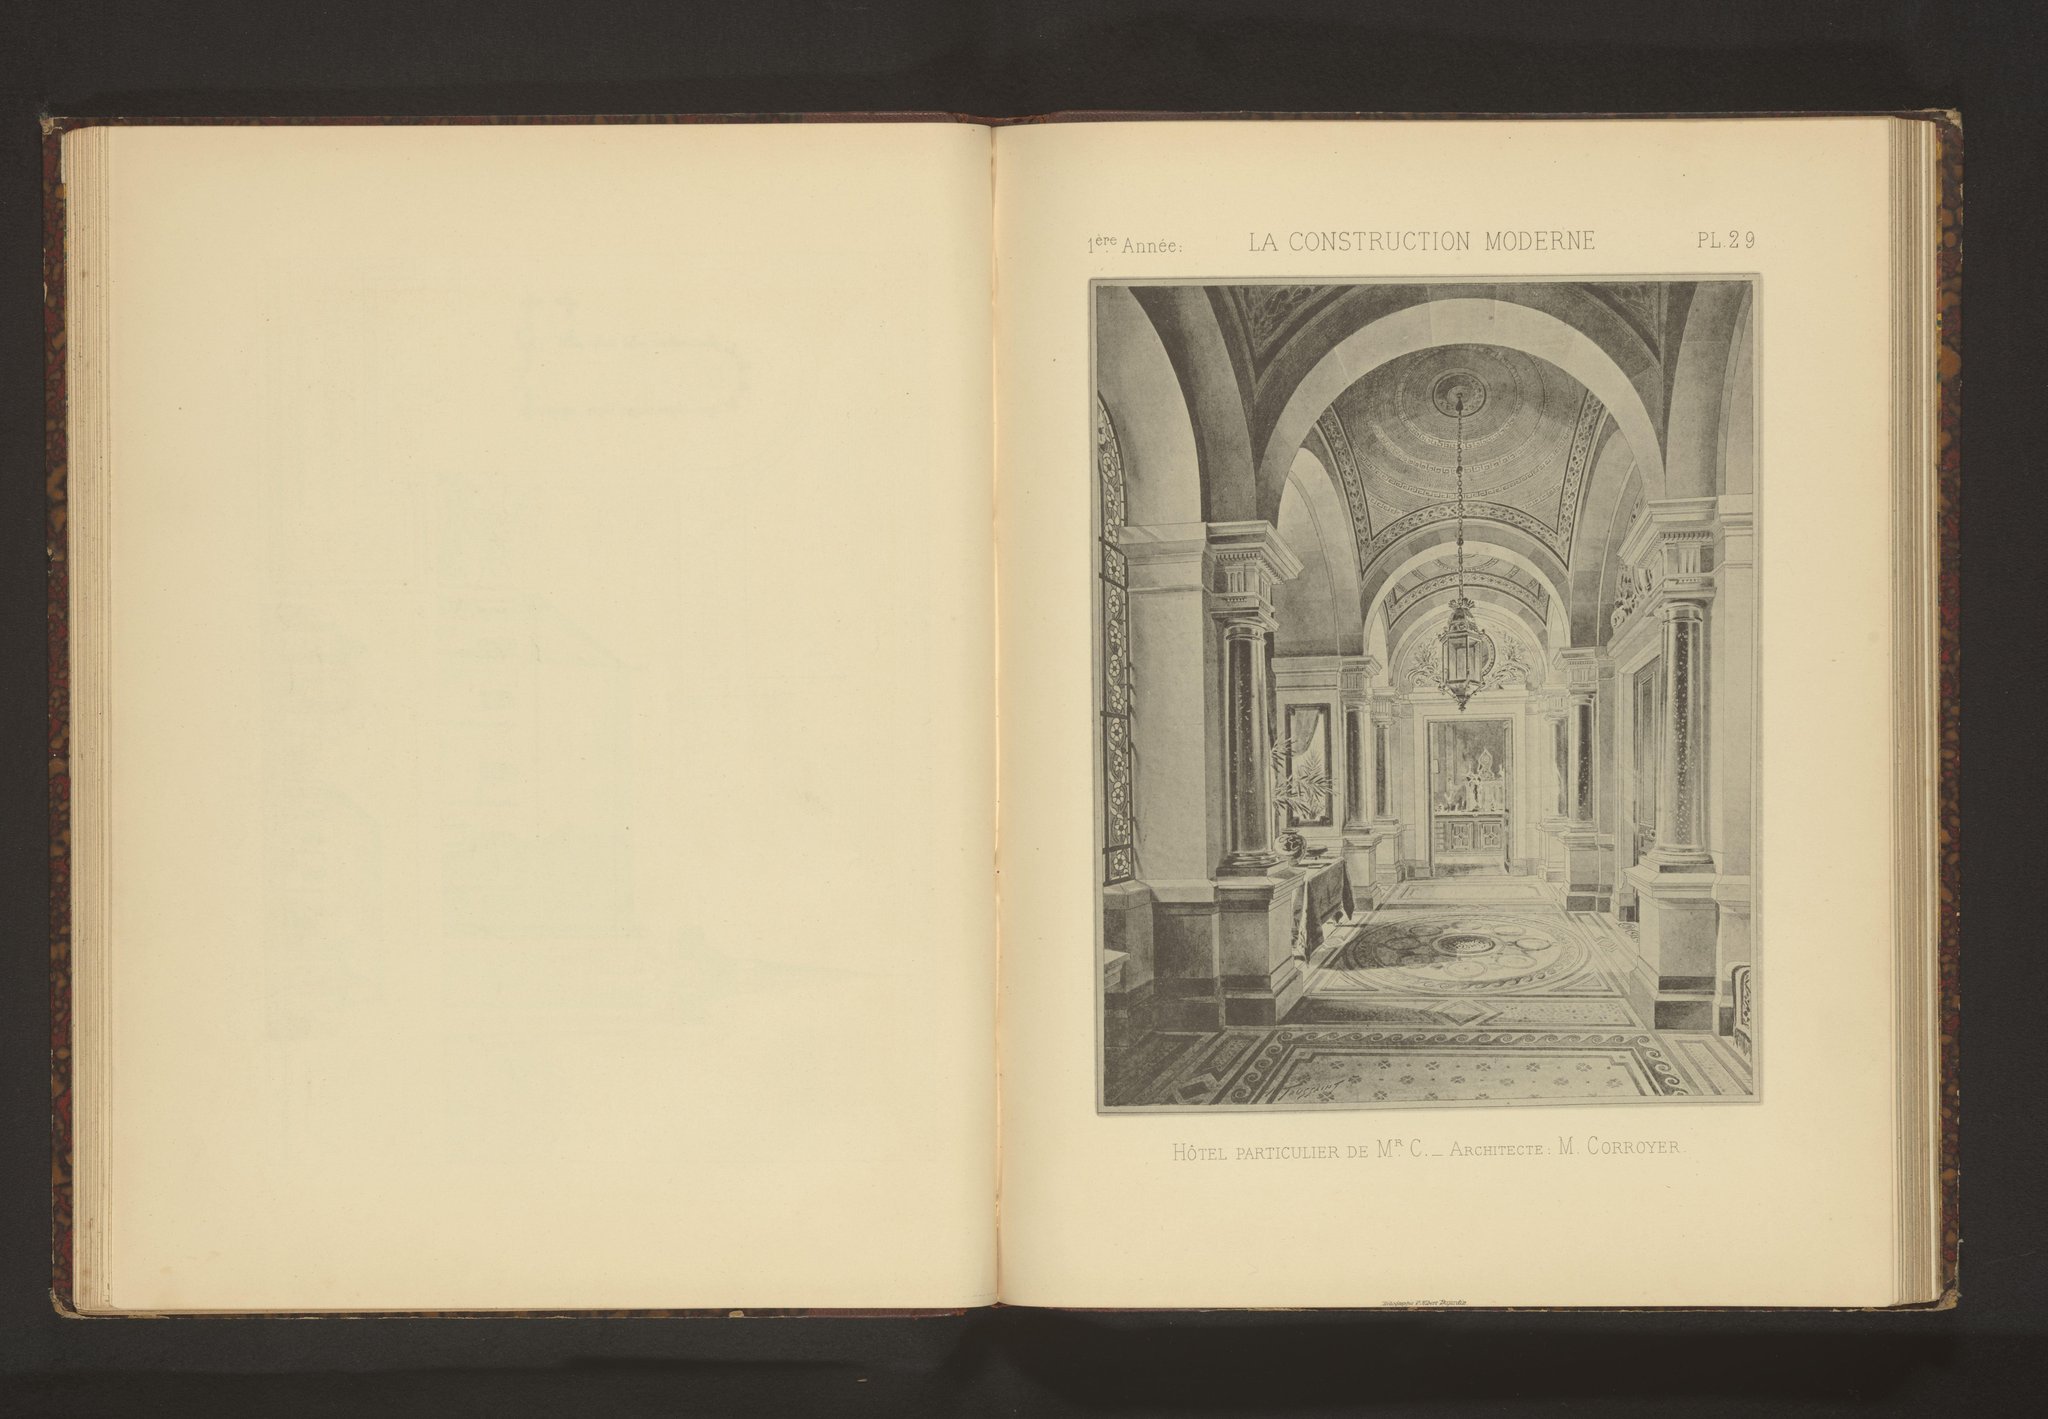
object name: photomechanical print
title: Reproductie van een prent van een gang in een stadspaleis door Henri Toussaint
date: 1881-1886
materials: paper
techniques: photograph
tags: corridor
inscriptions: inscription: ‘1ère Année: LA CONSTRUCTION MODERNE Pl. 29’, inscription: ‘Architecte: M. Corroyer.’